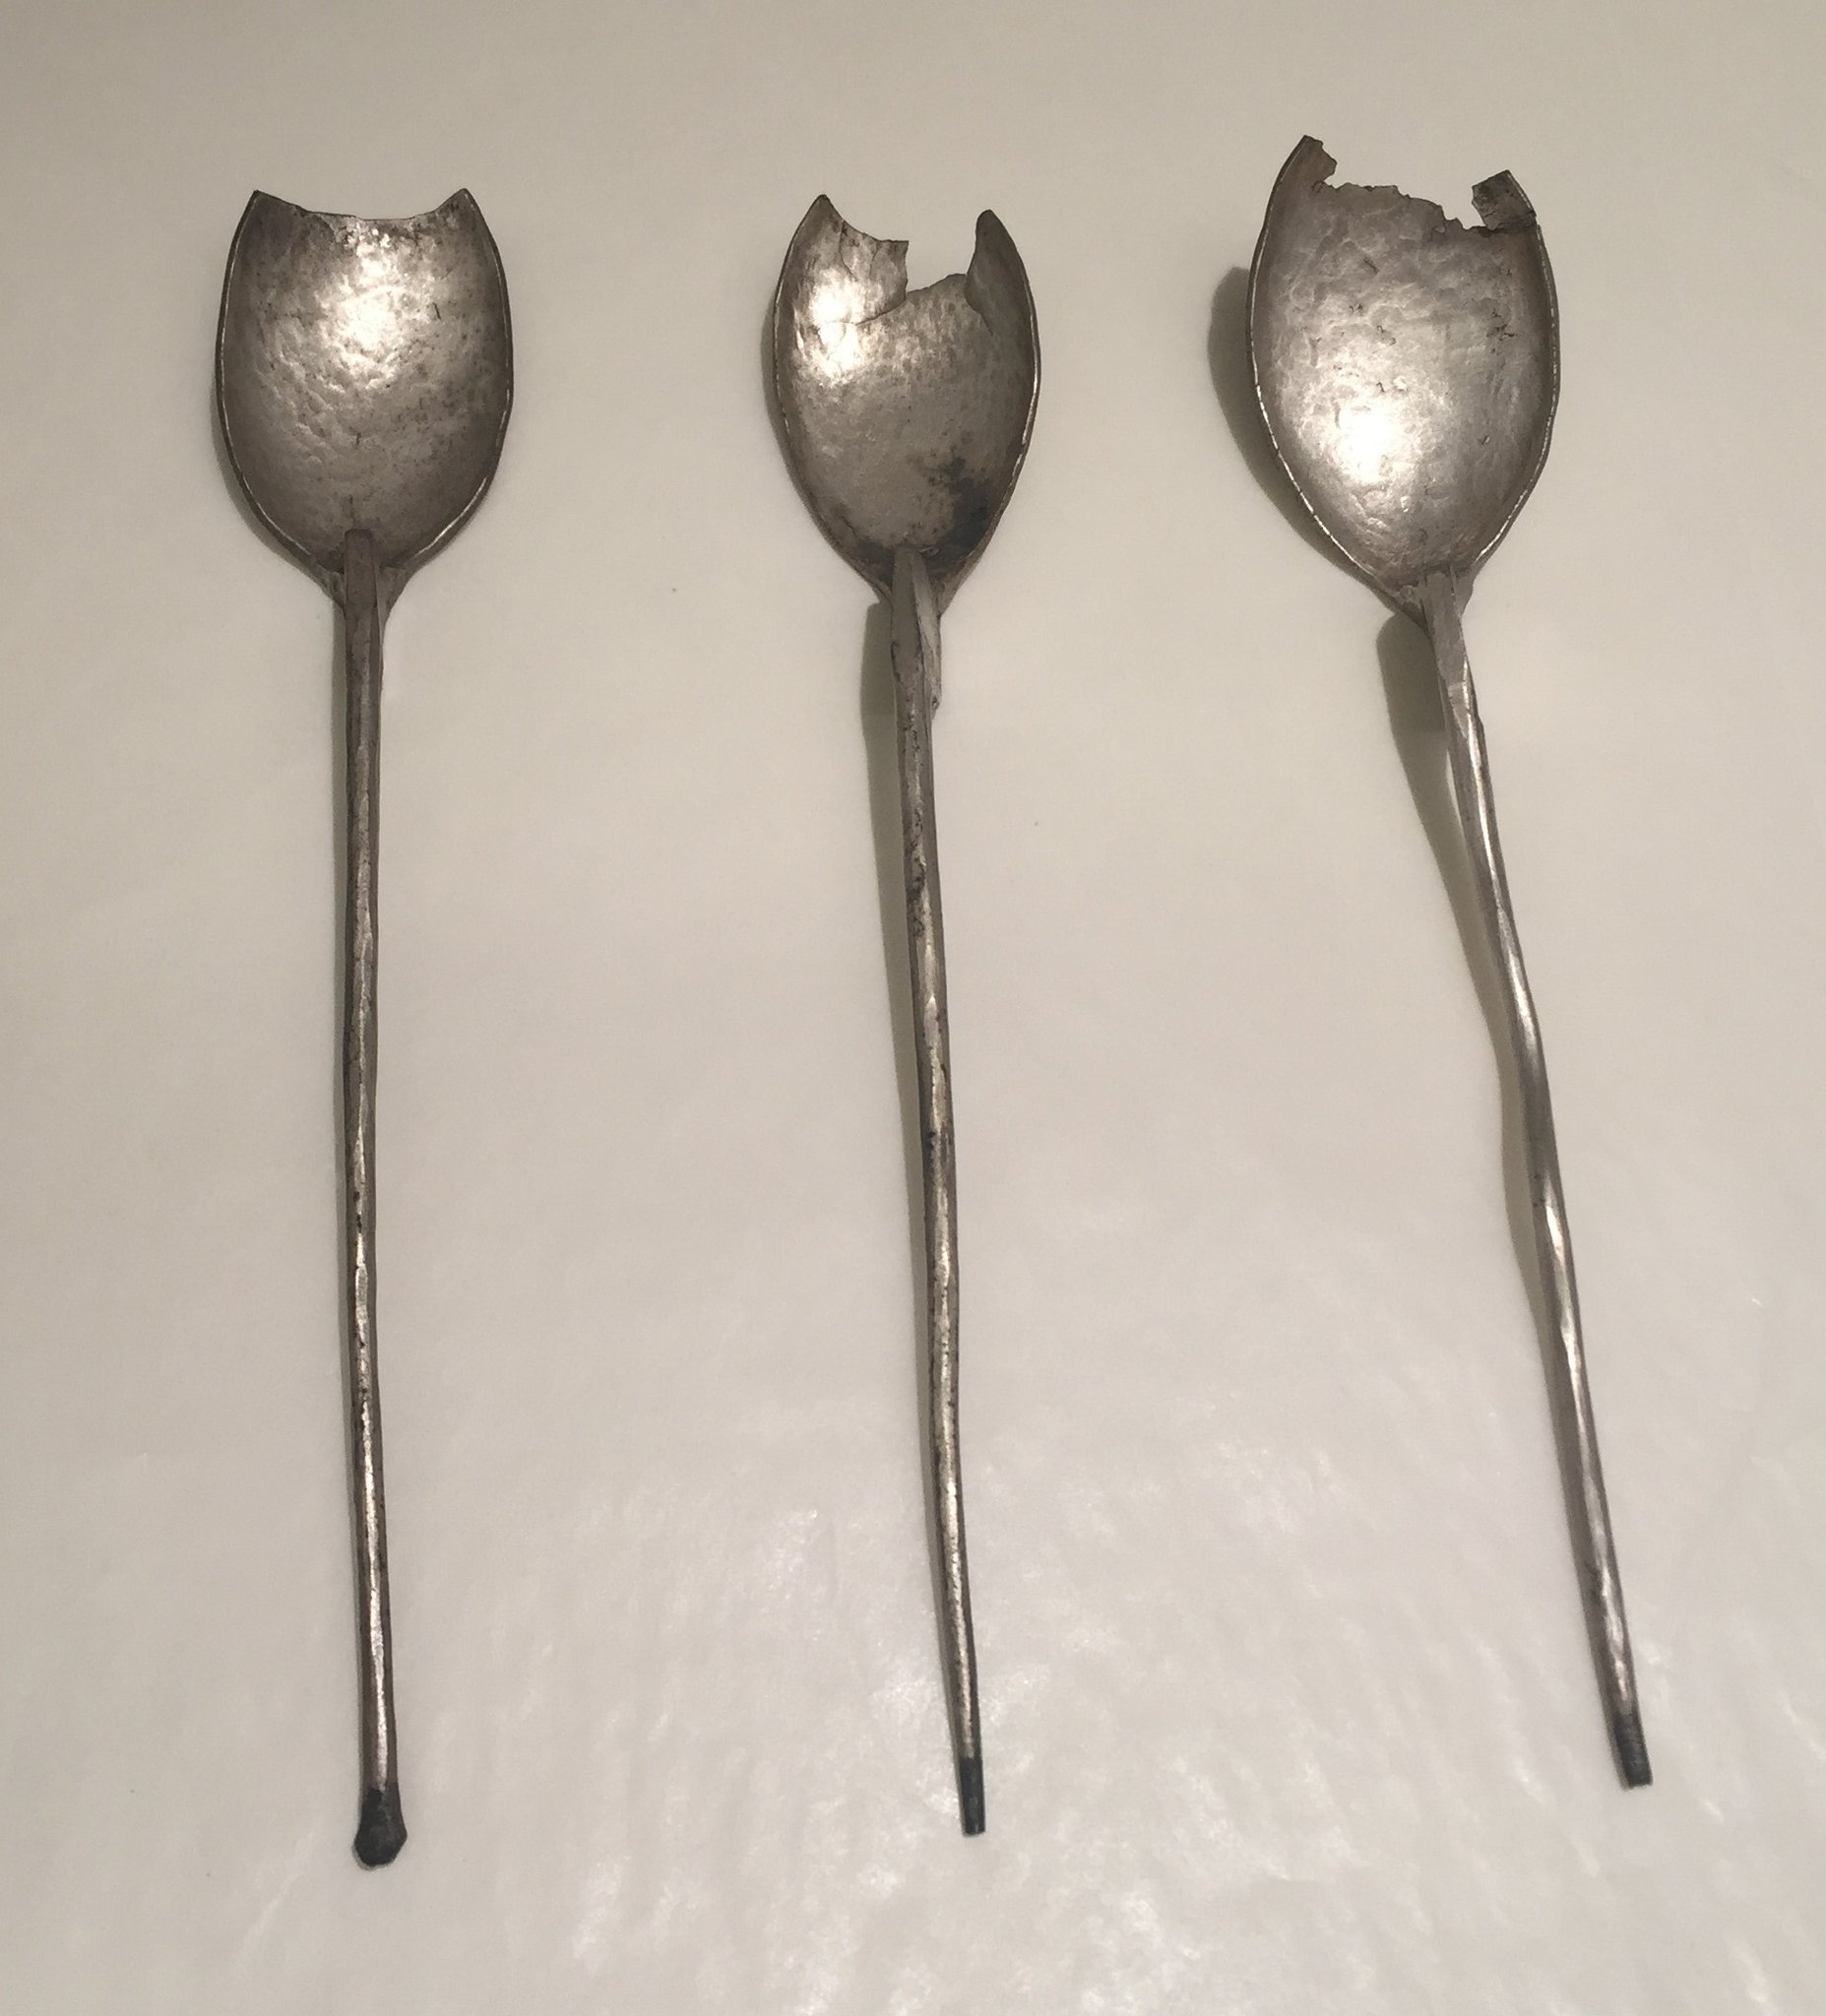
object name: spoon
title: Spoons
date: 1301-1400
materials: silver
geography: egypt